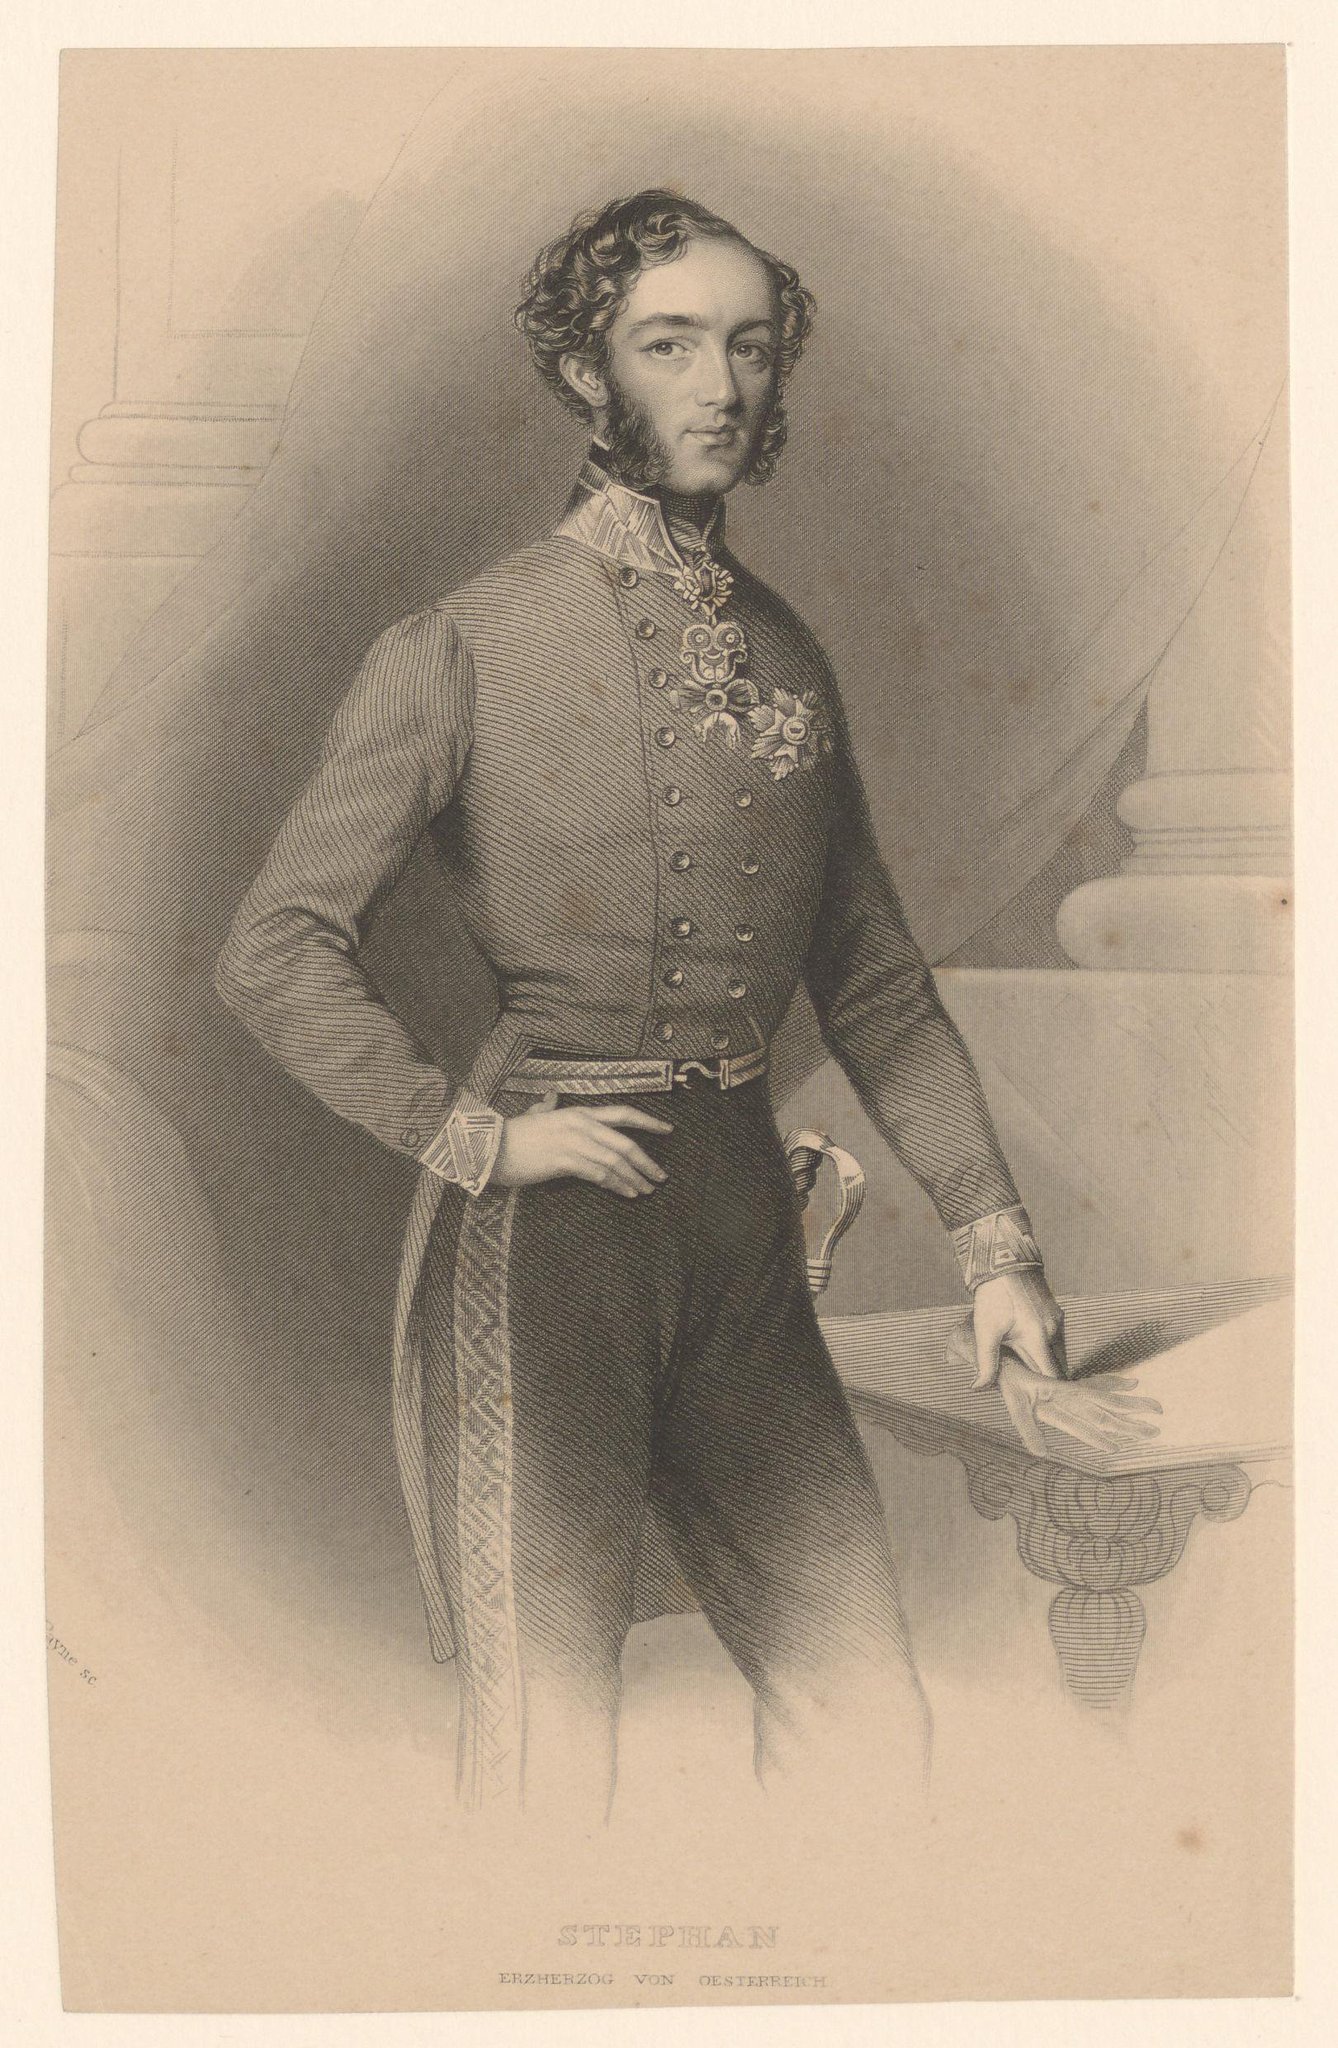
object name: print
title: Portret van Stephan Franz Viktor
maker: albert henry payne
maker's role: print maker, publisher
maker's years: 1812-1902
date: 1838-1902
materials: paper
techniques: engraving, etching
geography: leipzig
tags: historical persons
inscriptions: collector's mark: Lugt 2228